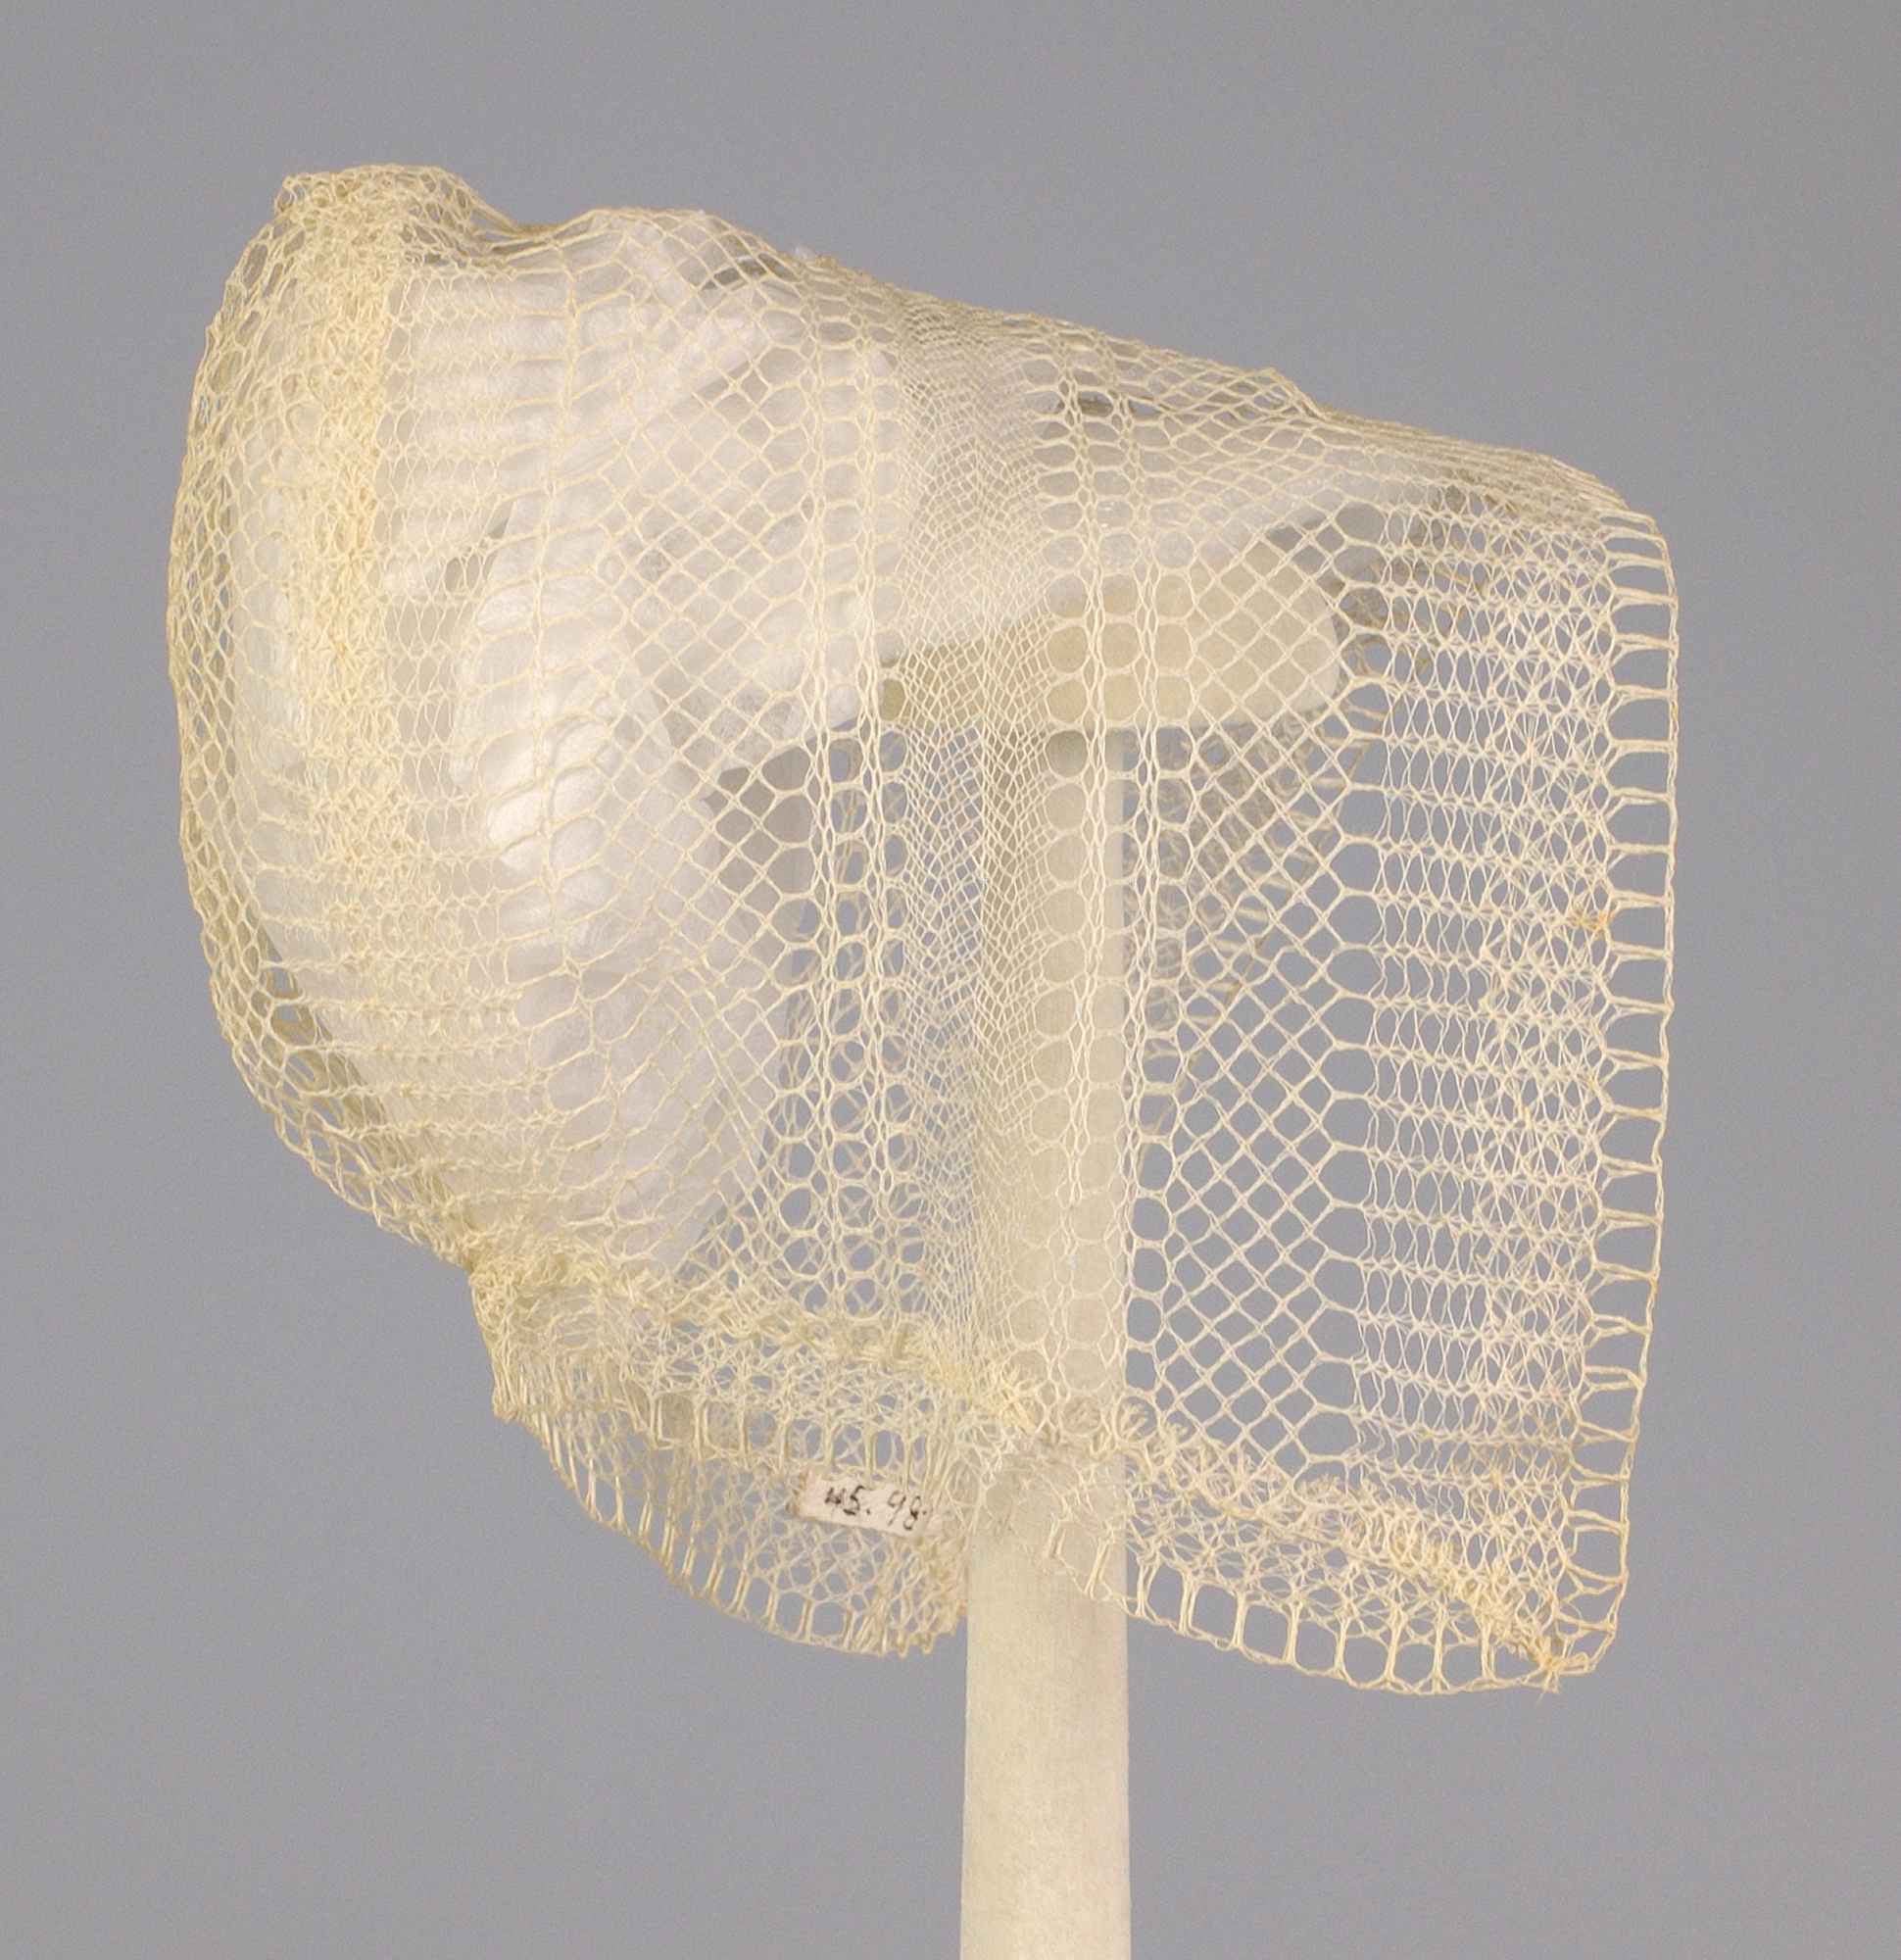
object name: nightcap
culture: american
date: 1854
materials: cotton